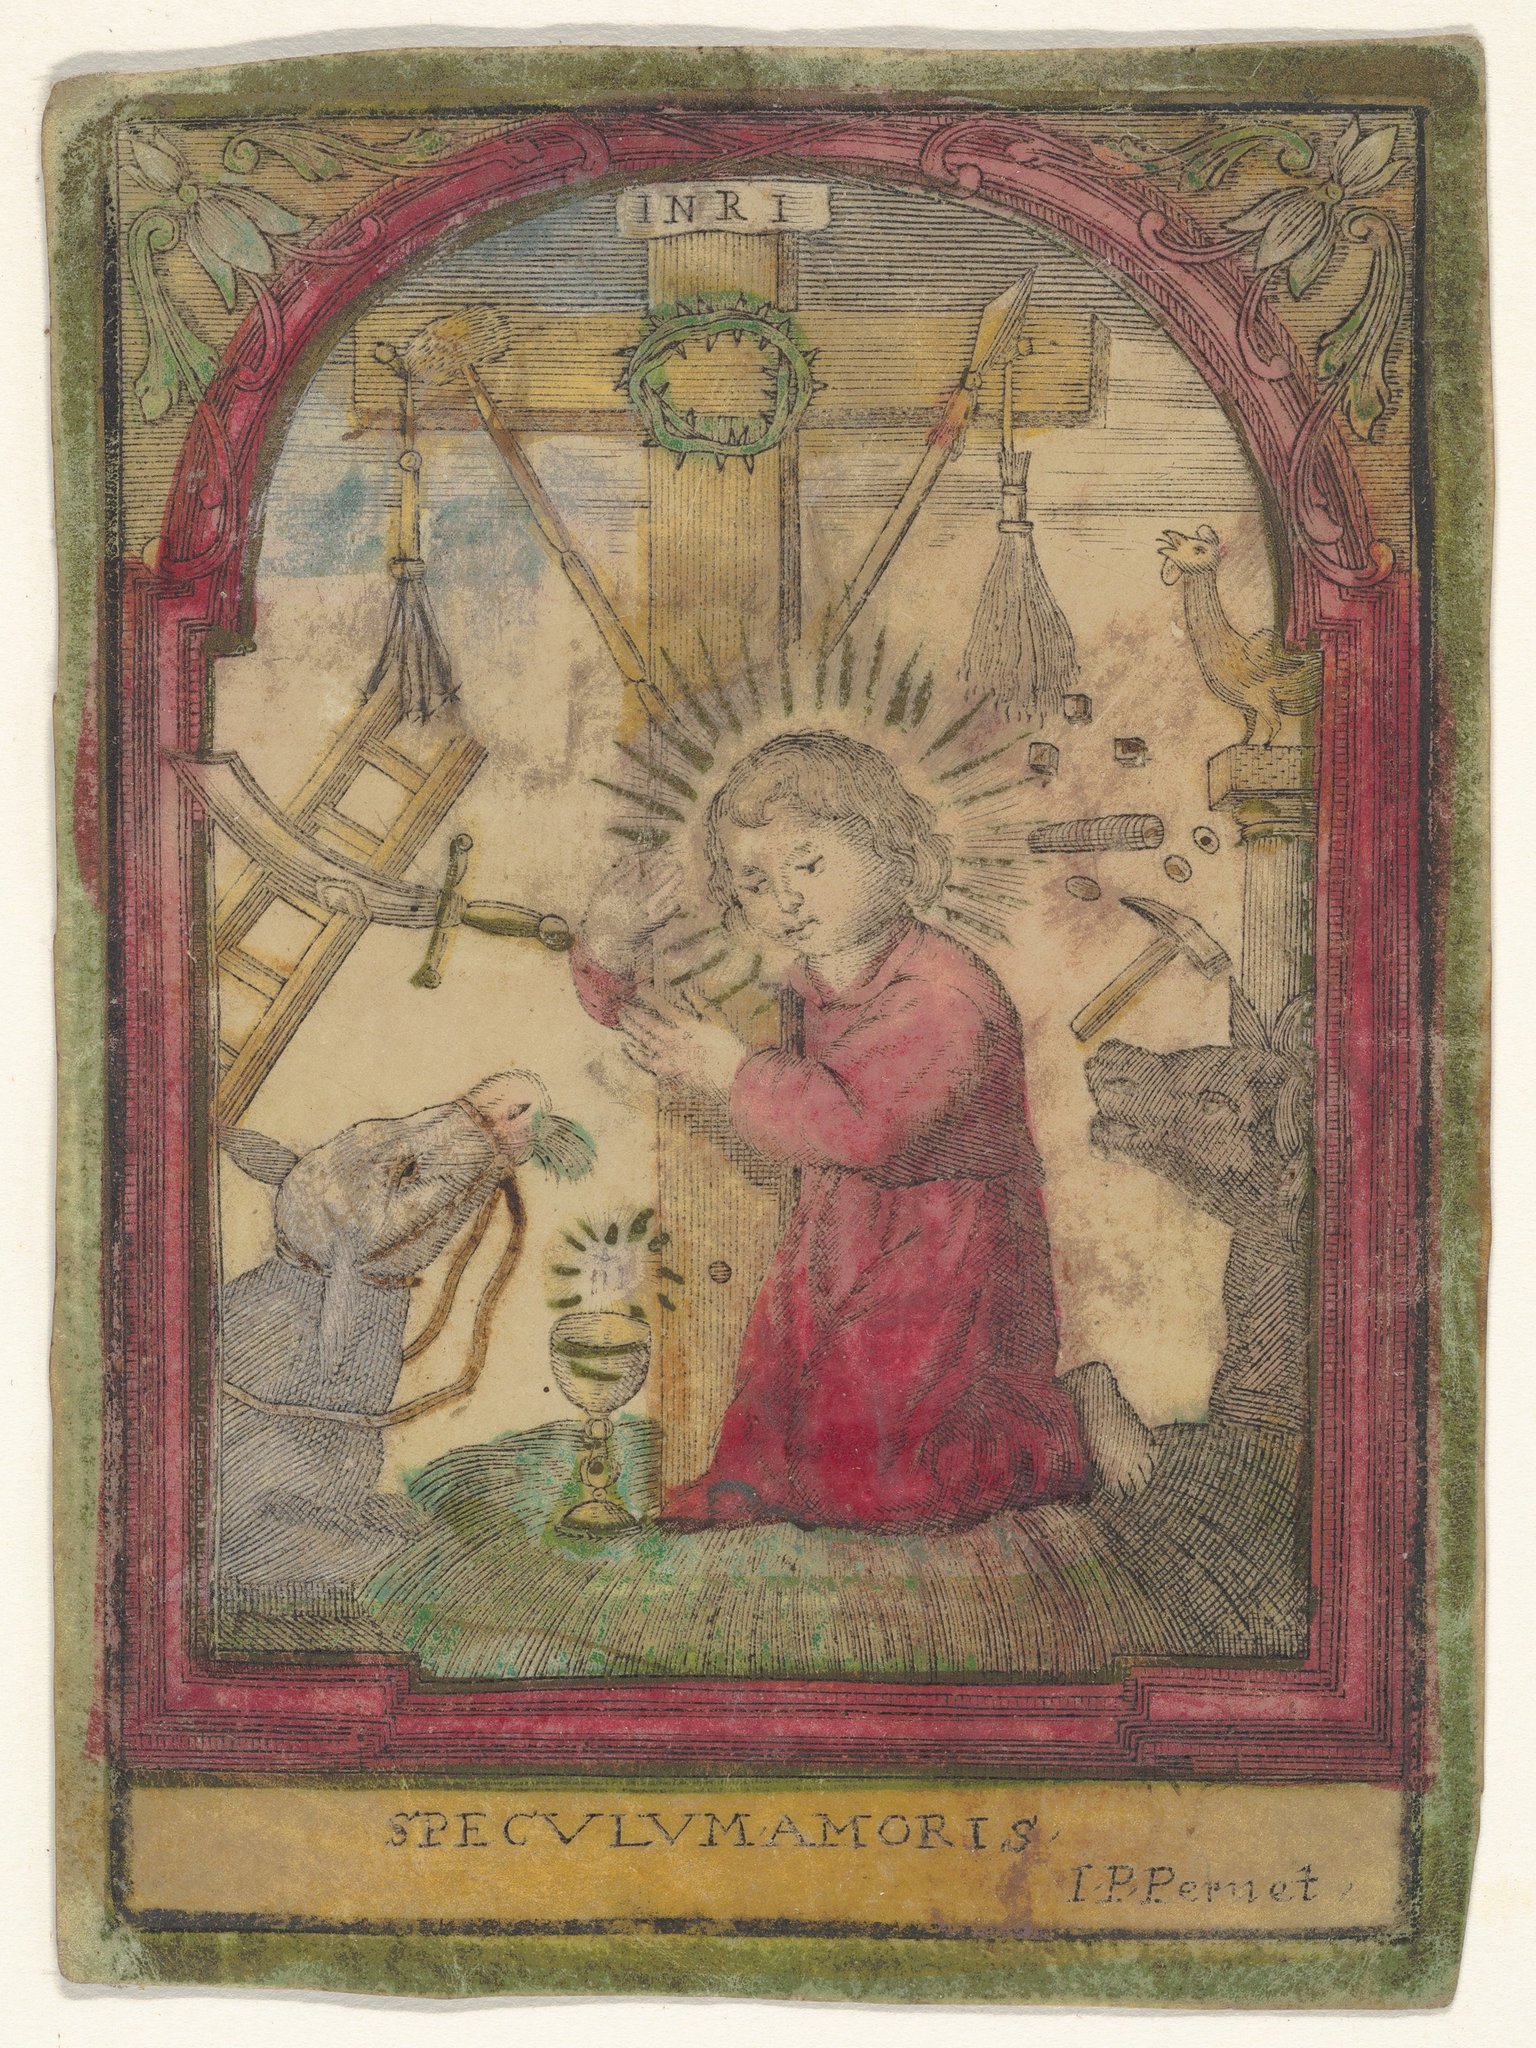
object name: print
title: Christ Child with Instruments of the Passion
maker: Anonymous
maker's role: artist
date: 1550-1650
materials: parchment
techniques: engraving, hand coloring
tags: animals,christ,cross